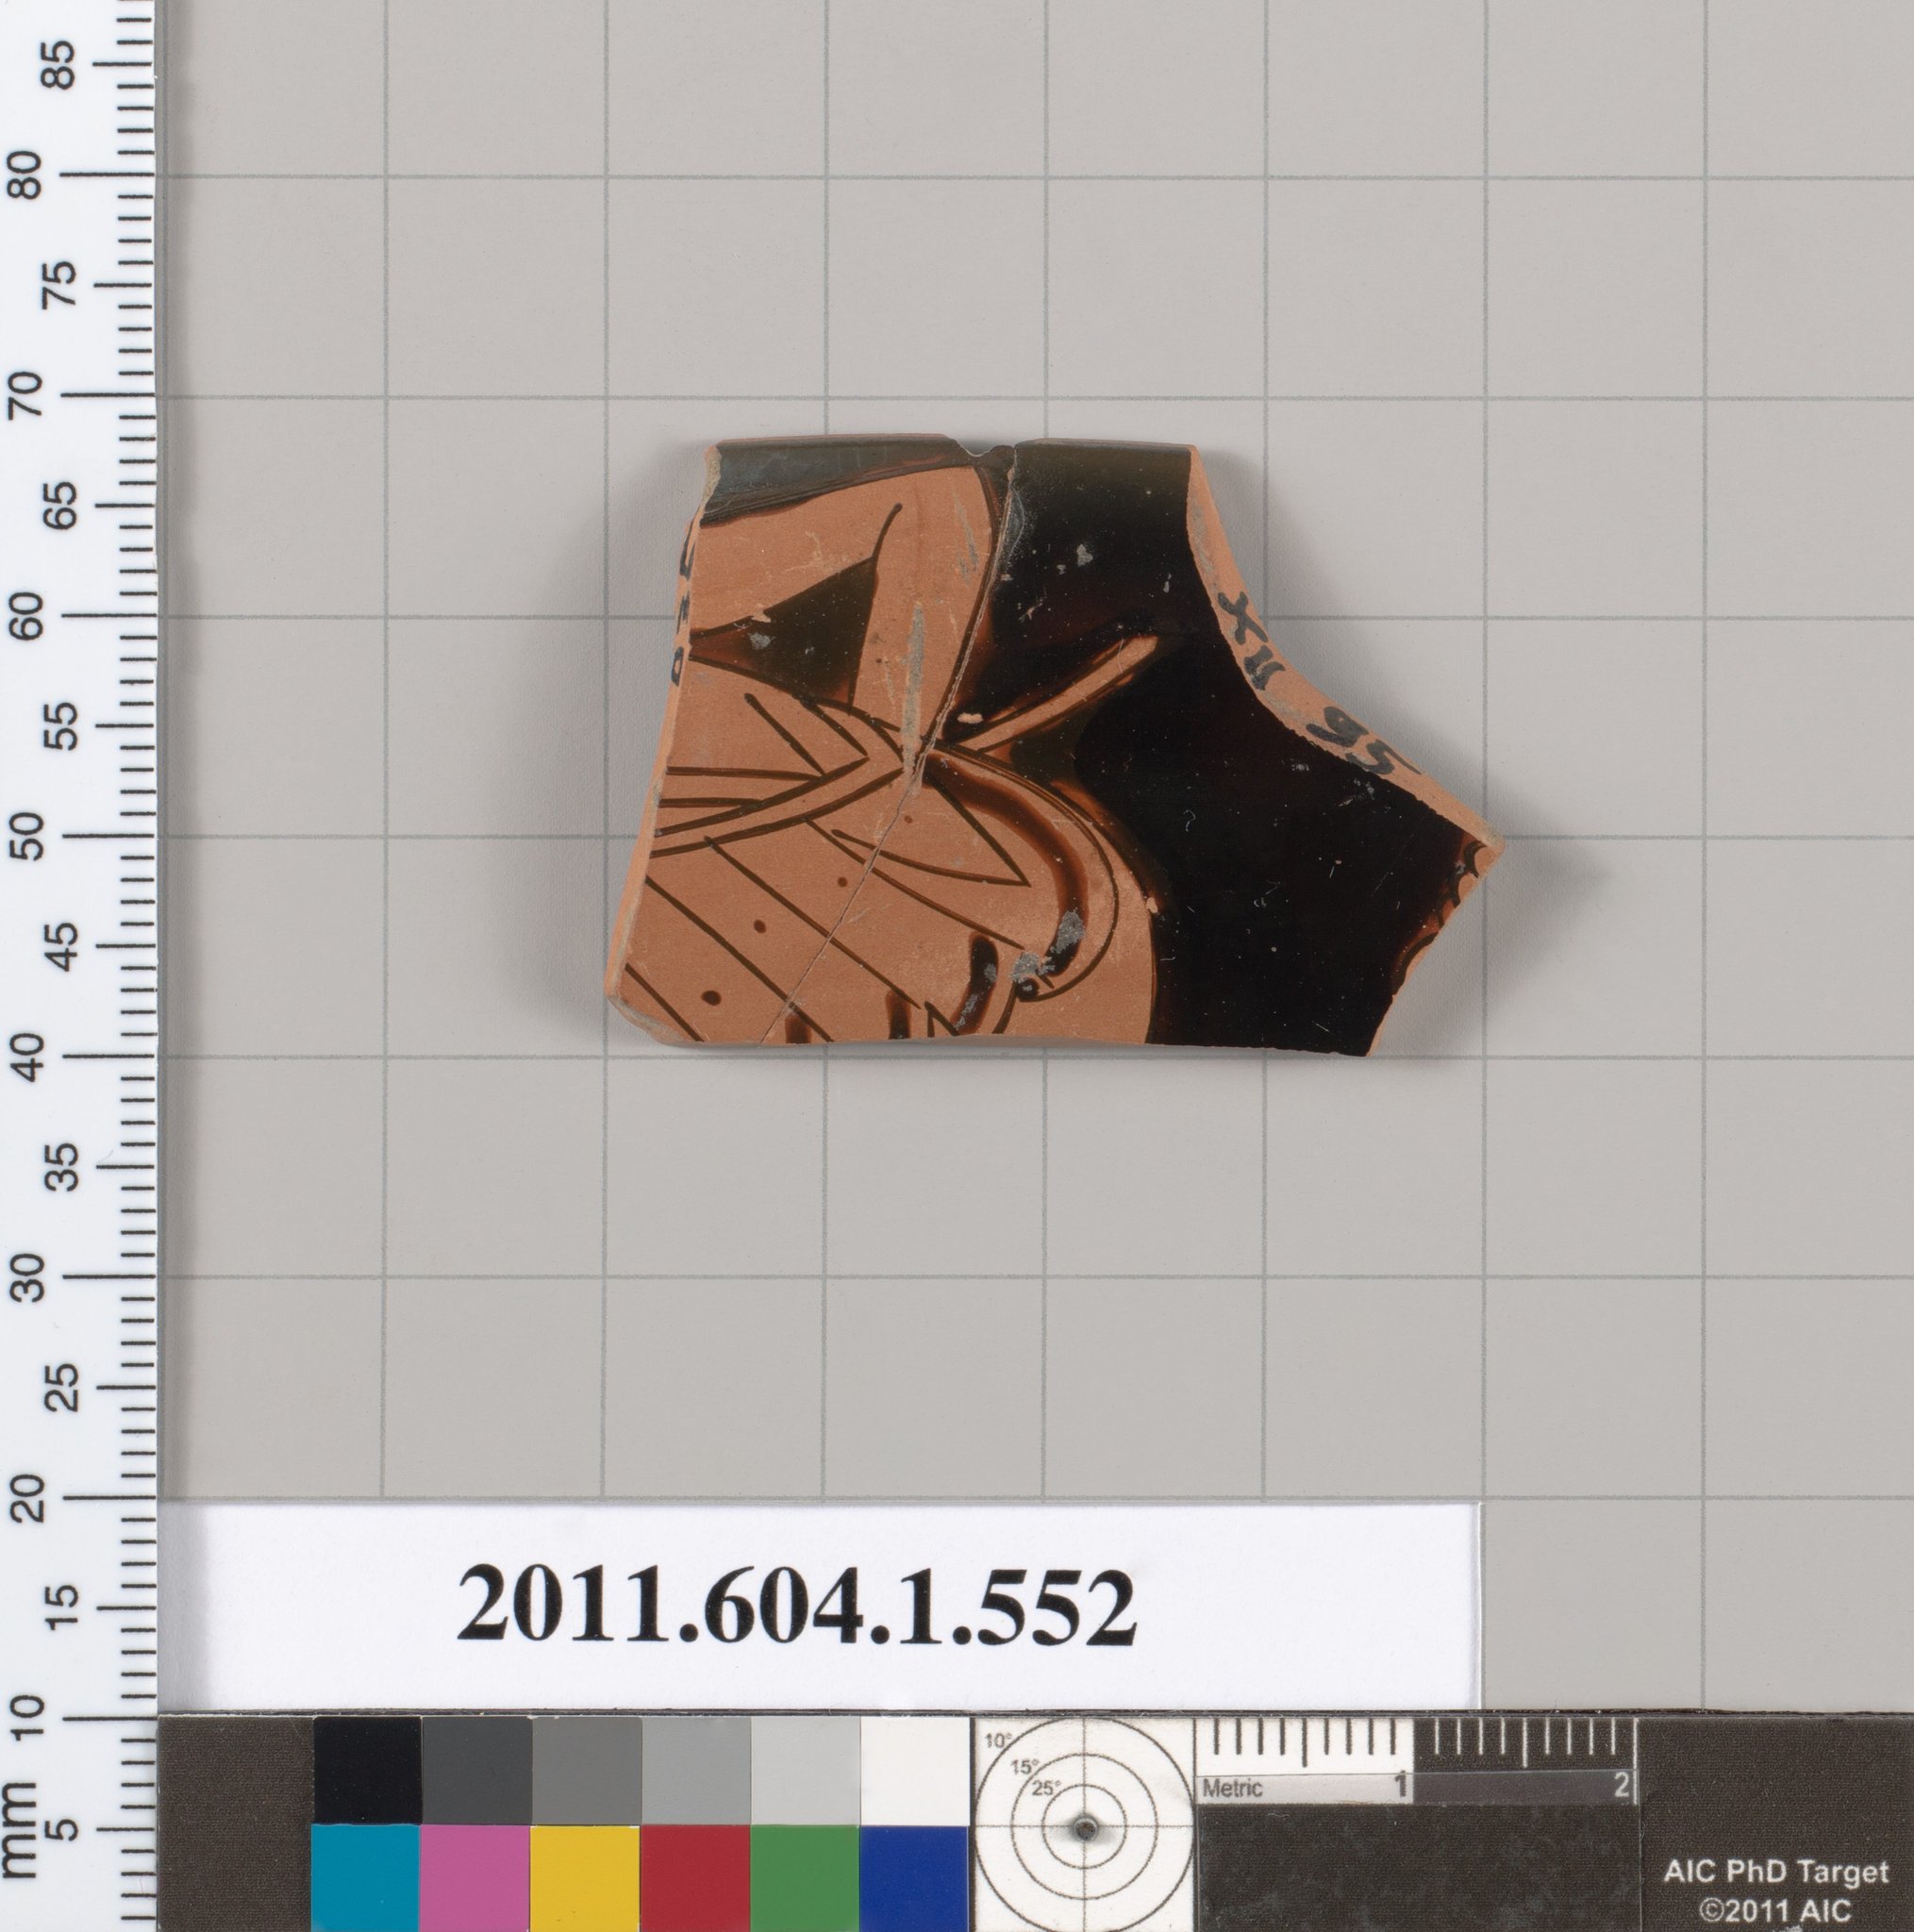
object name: kylix fragment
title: Terracotta rim fragment of a kylix (drinking cup)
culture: greek, attic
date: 480-470 BCE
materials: terracotta